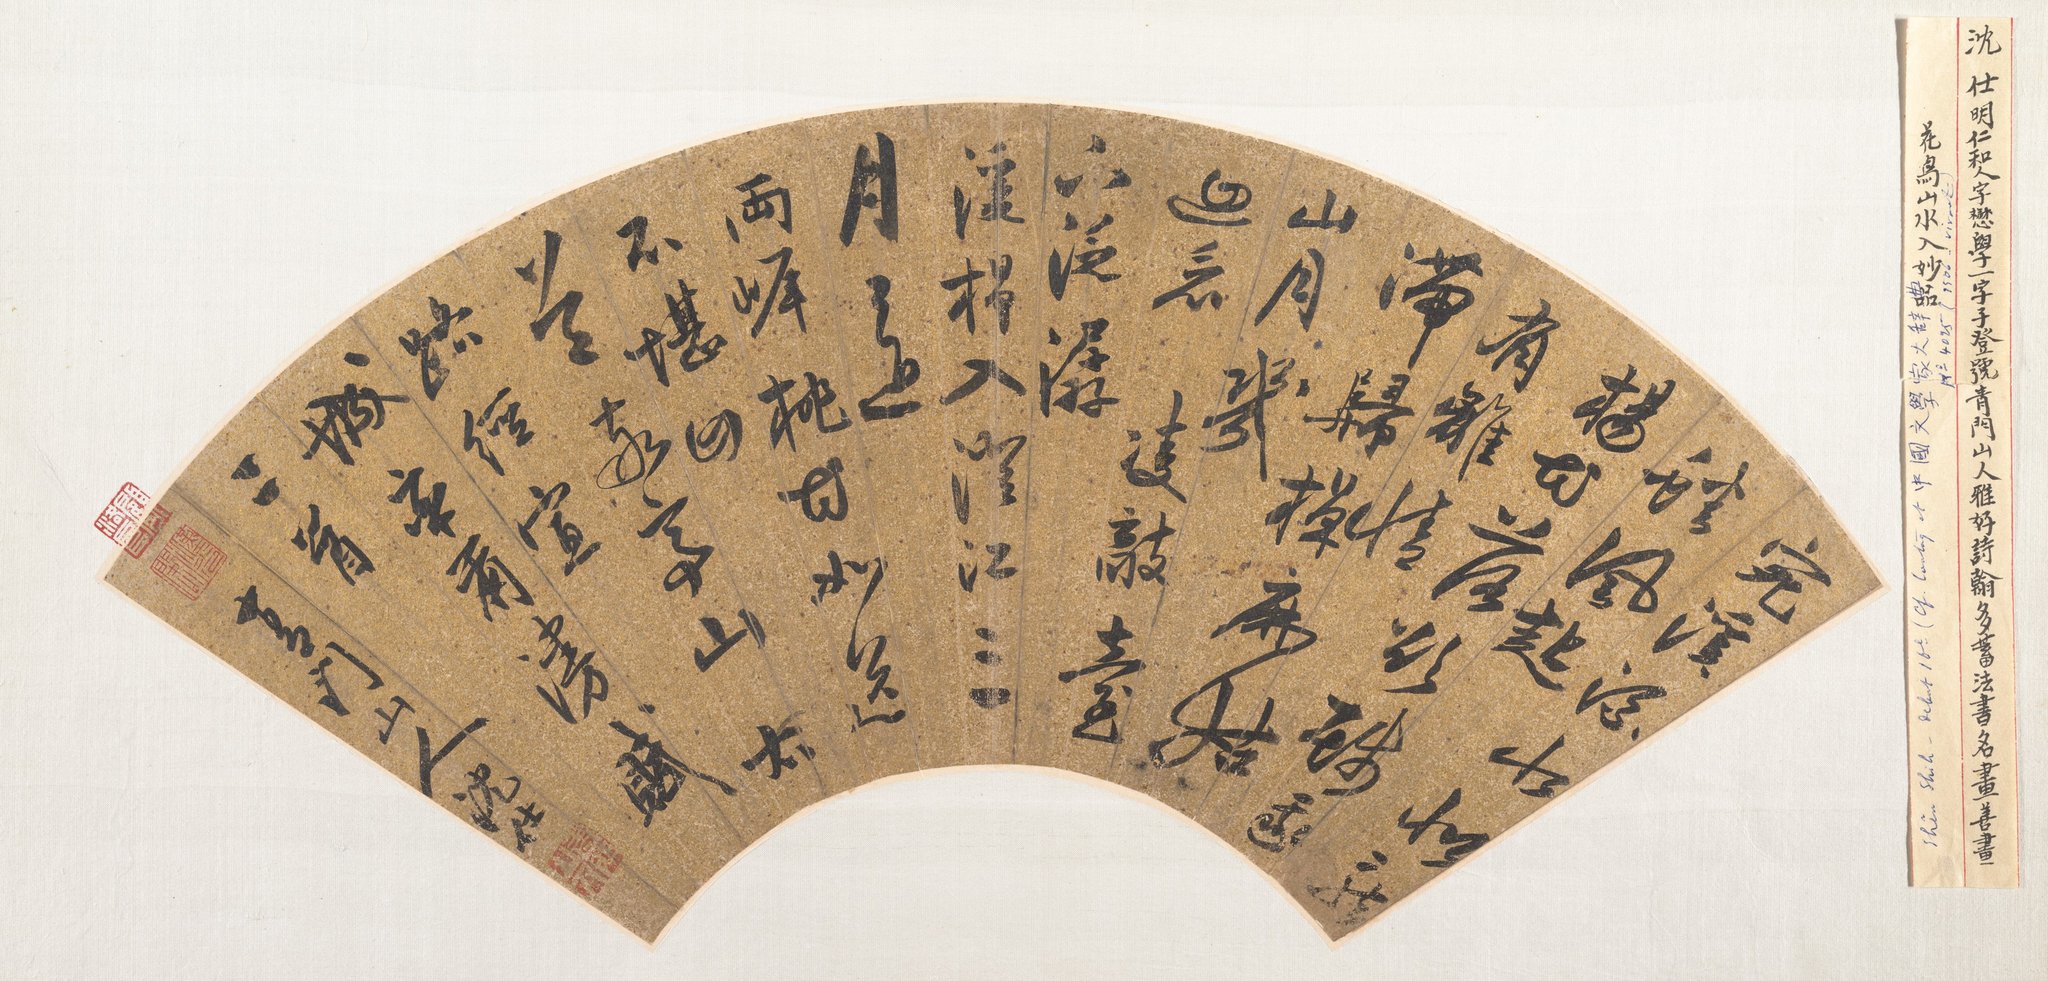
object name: folding fan mounted a an album leaf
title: Two Poems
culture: chinese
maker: shen shi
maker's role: artist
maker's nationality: chinese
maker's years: 1488-1565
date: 1500-1533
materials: gold, ink, paper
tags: poetry